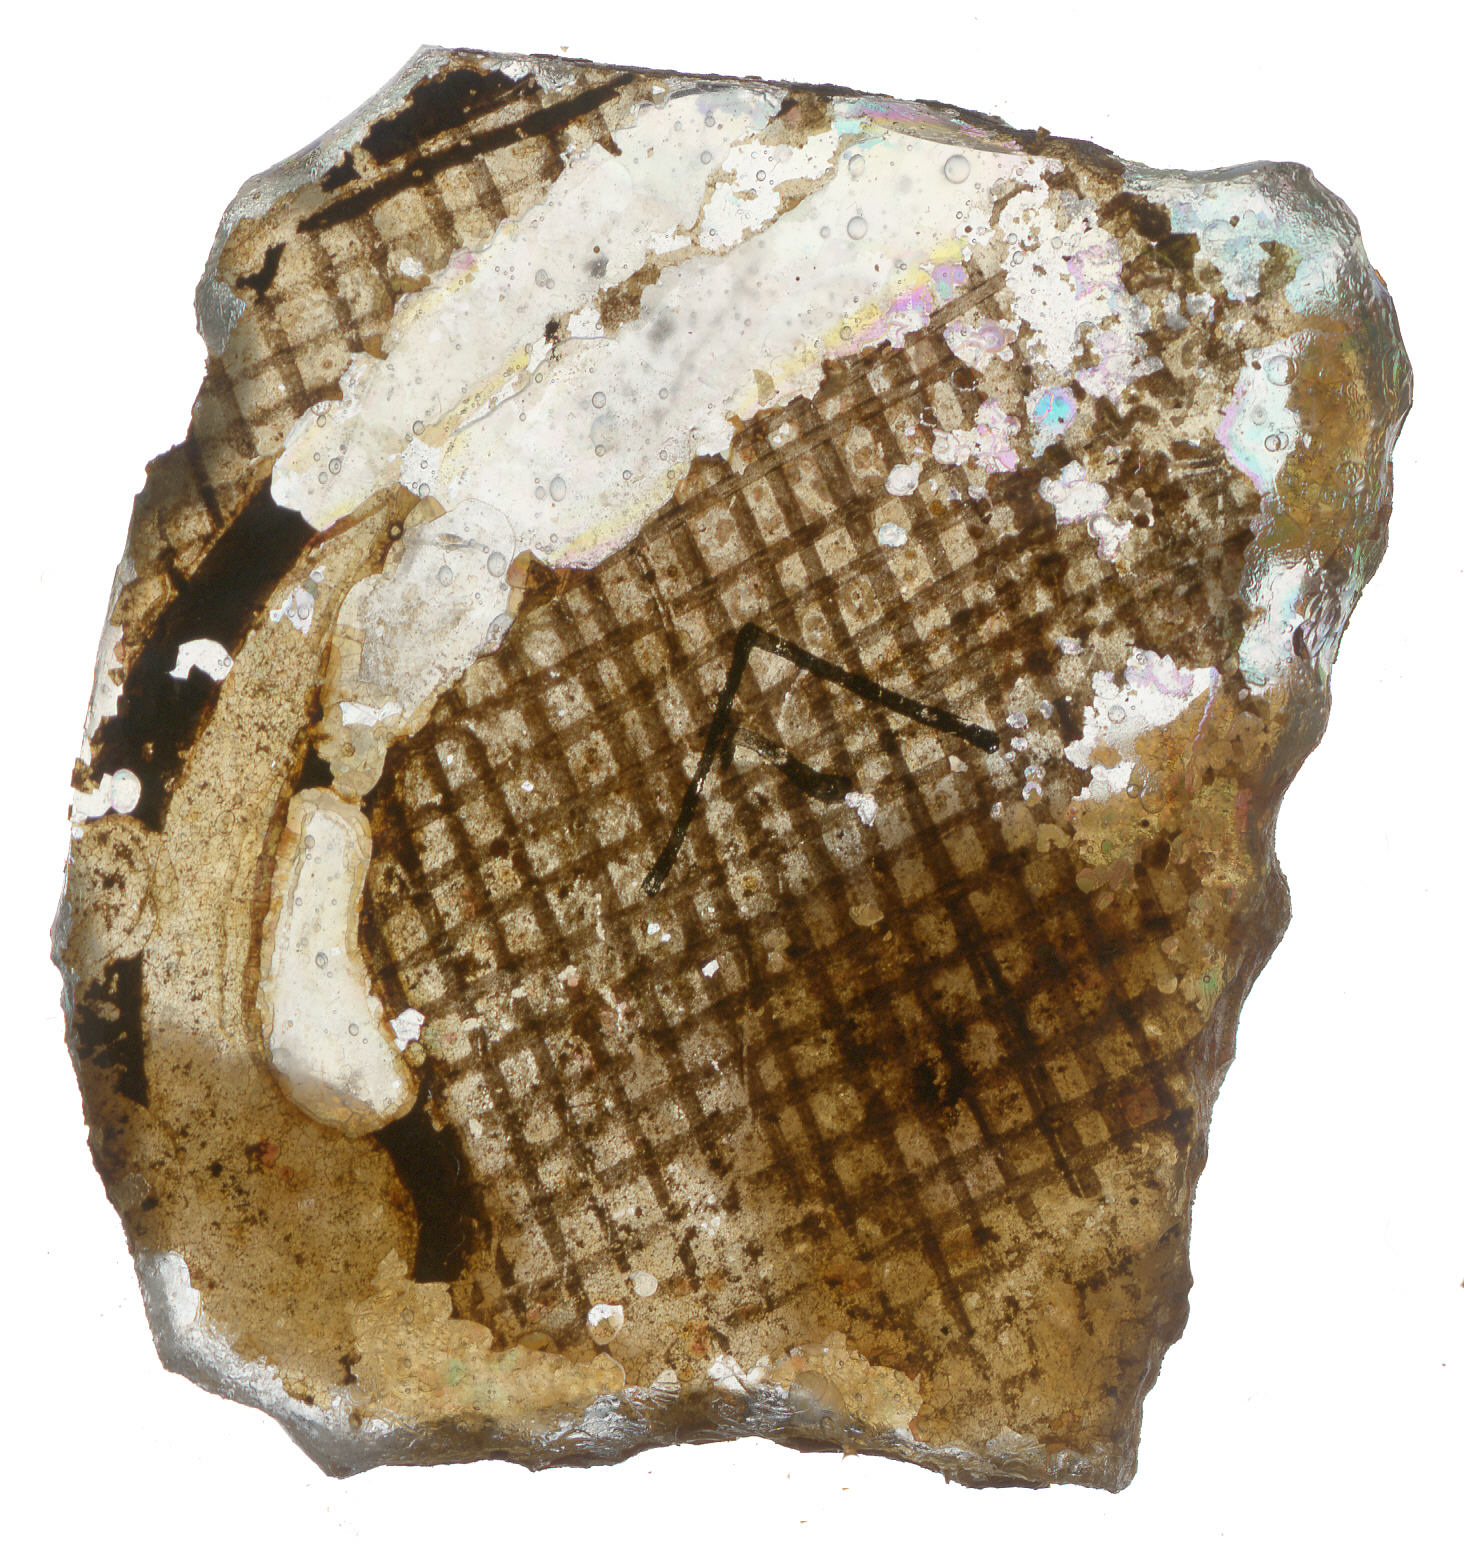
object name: fragment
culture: crusader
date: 1201-1300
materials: glass